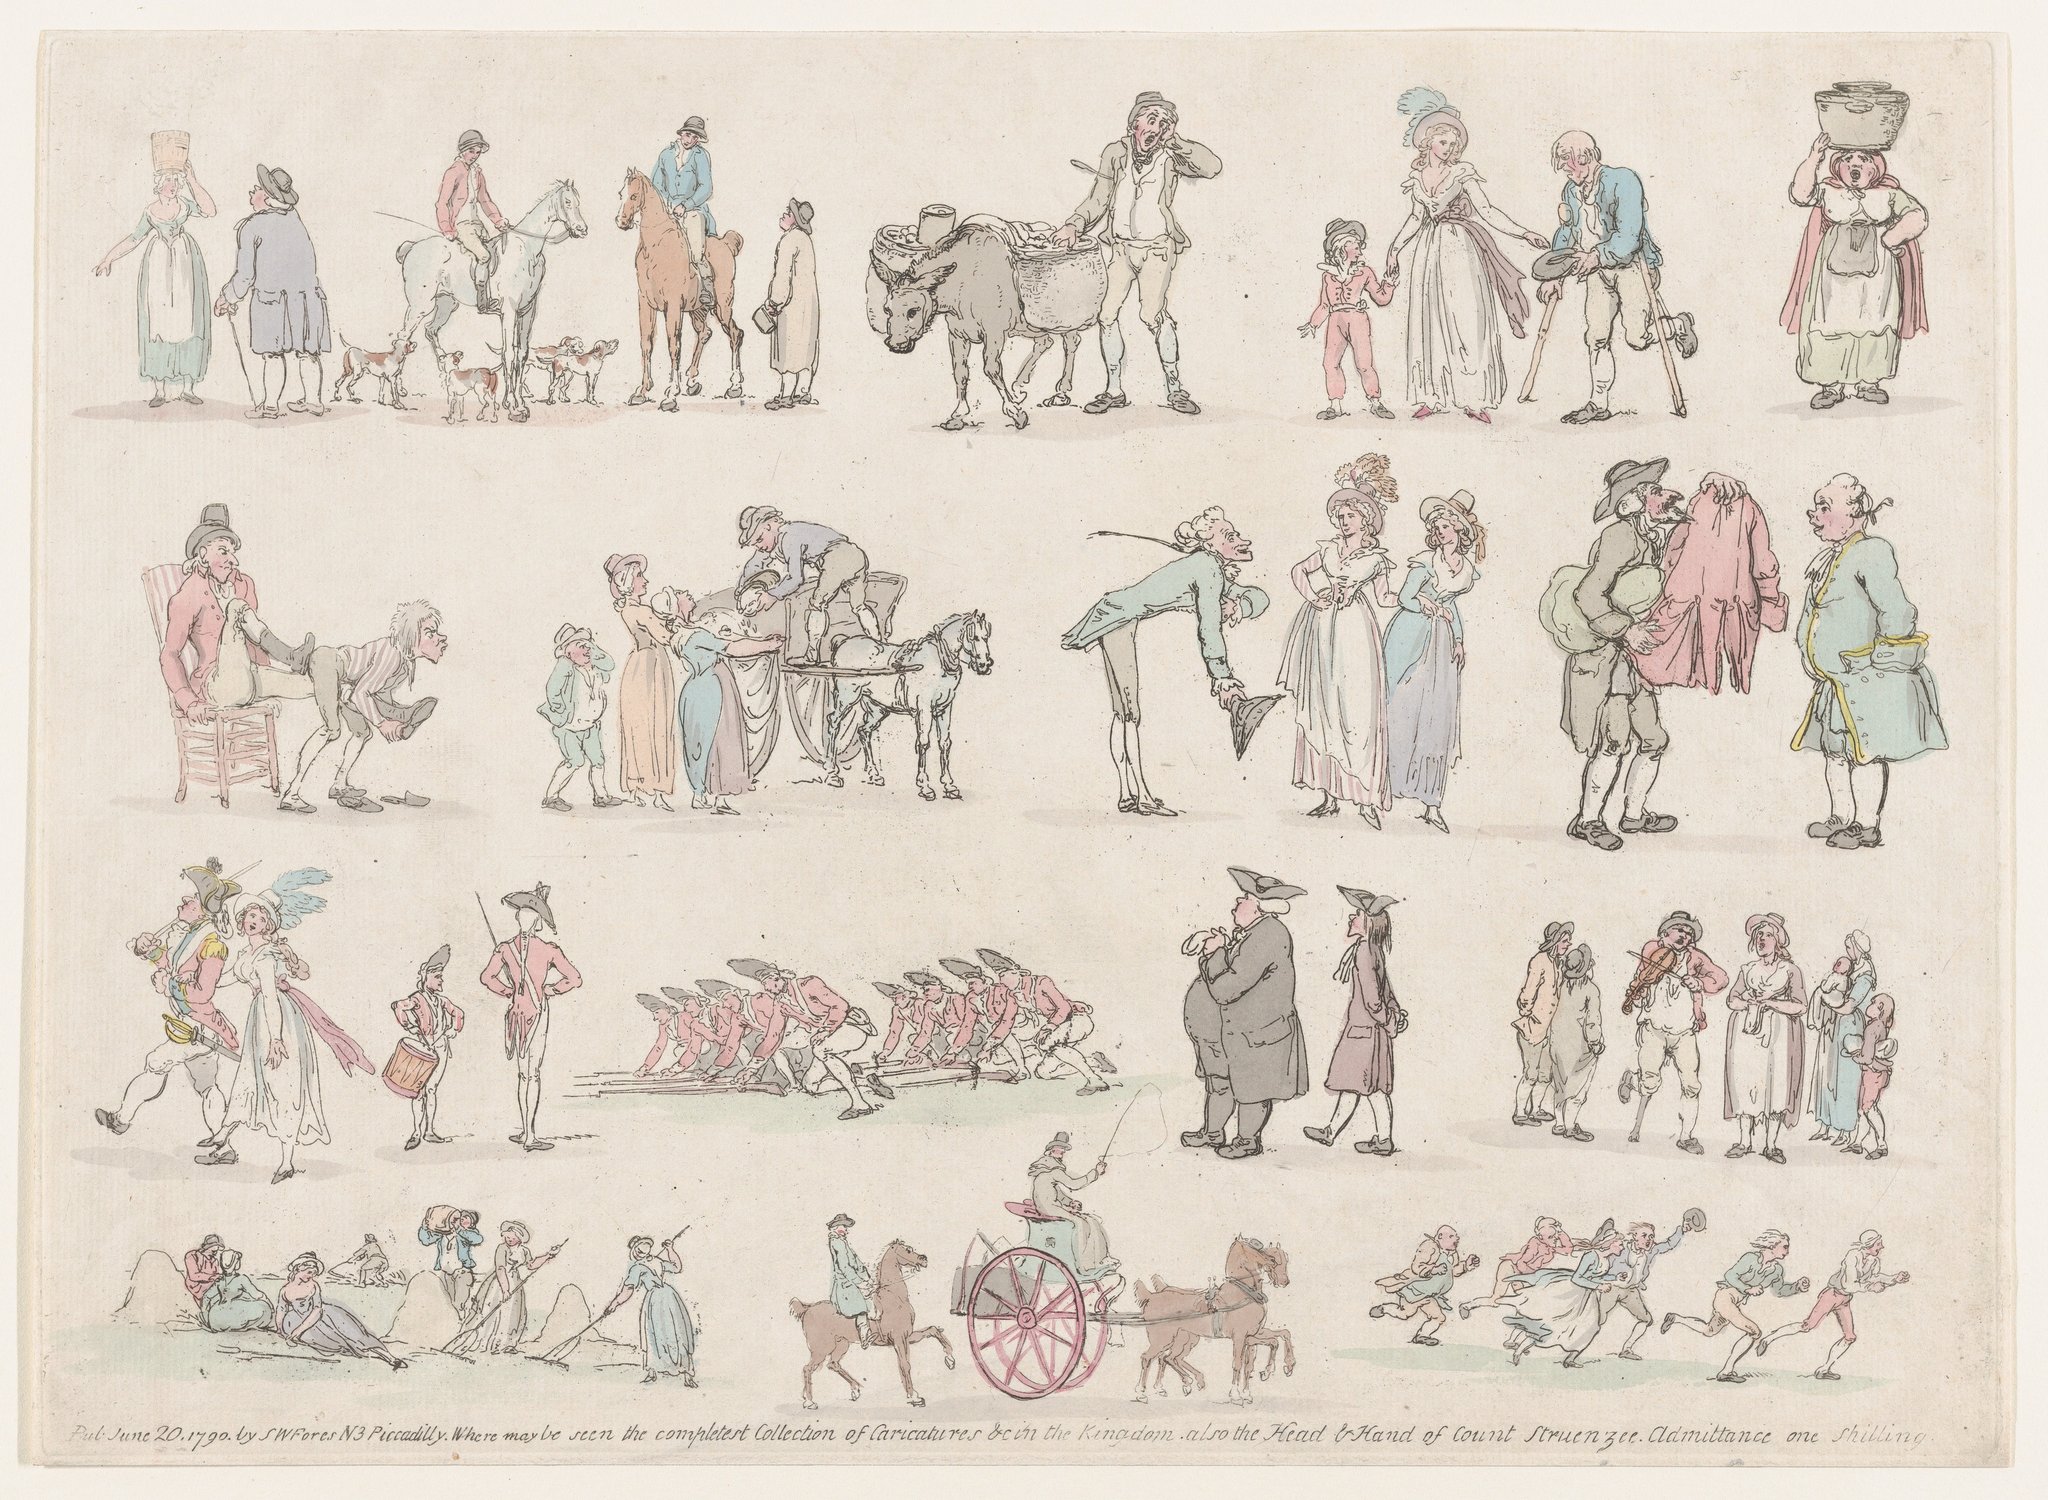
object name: print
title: Plate 6, Outlines of Figures, Landscapes and Cattle...for the Use of Learners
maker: thomas rowlandson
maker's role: artist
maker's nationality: british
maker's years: 1757-1827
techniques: etching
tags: soldiers,men,women,horses